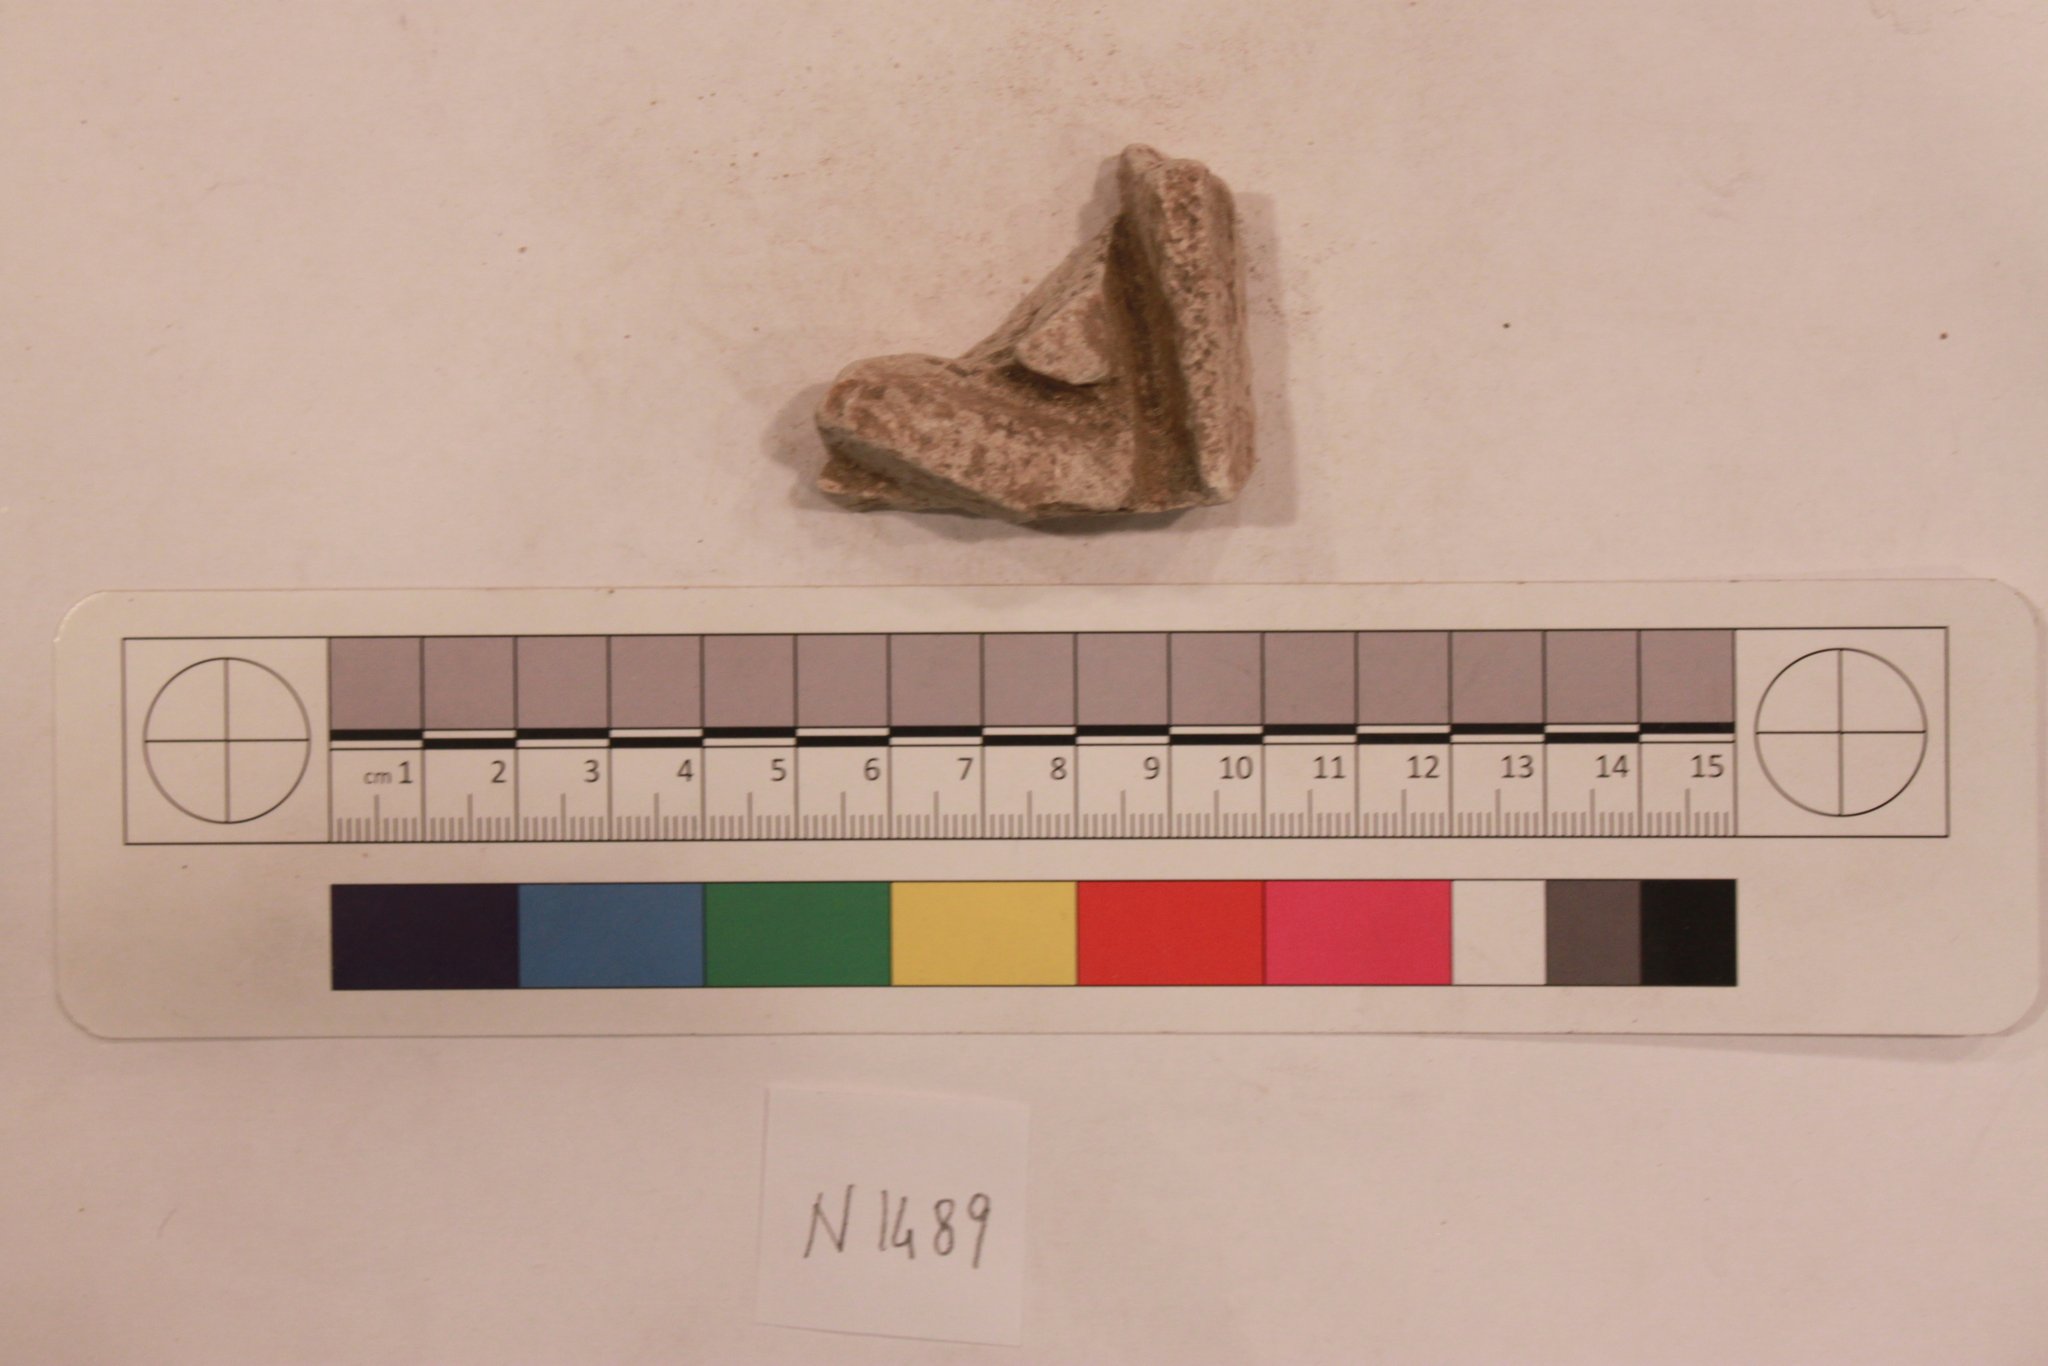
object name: fragment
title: Stucco Fragment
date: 701-1200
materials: plaster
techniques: carving, painting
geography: iran